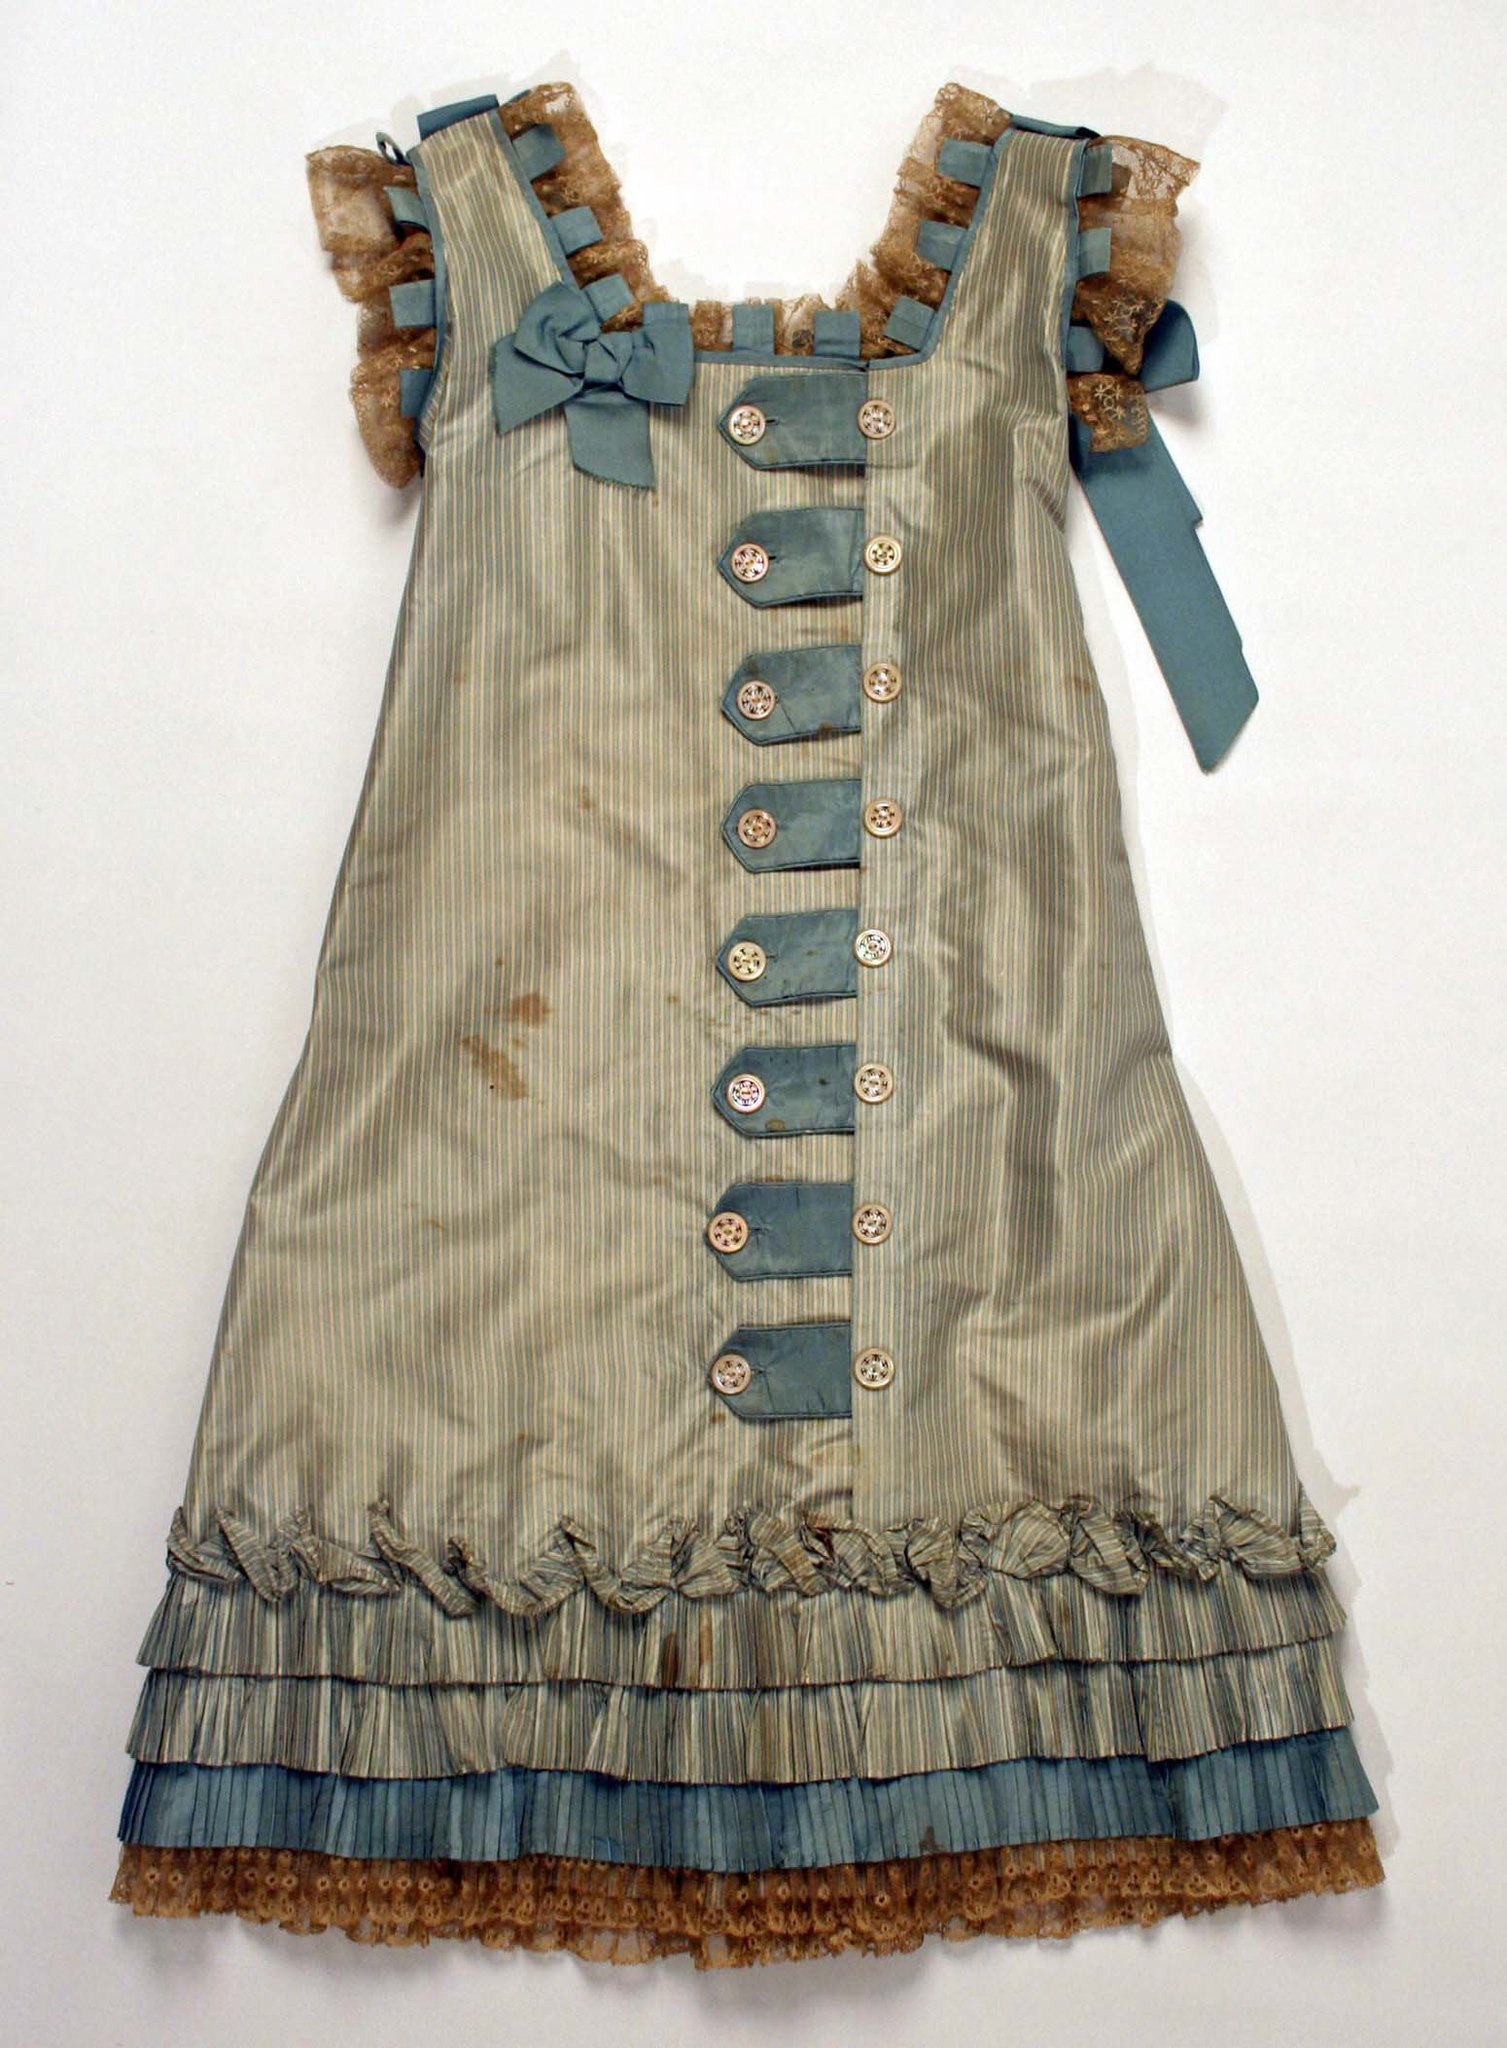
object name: dress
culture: american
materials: cotton, mother of pearl, silk